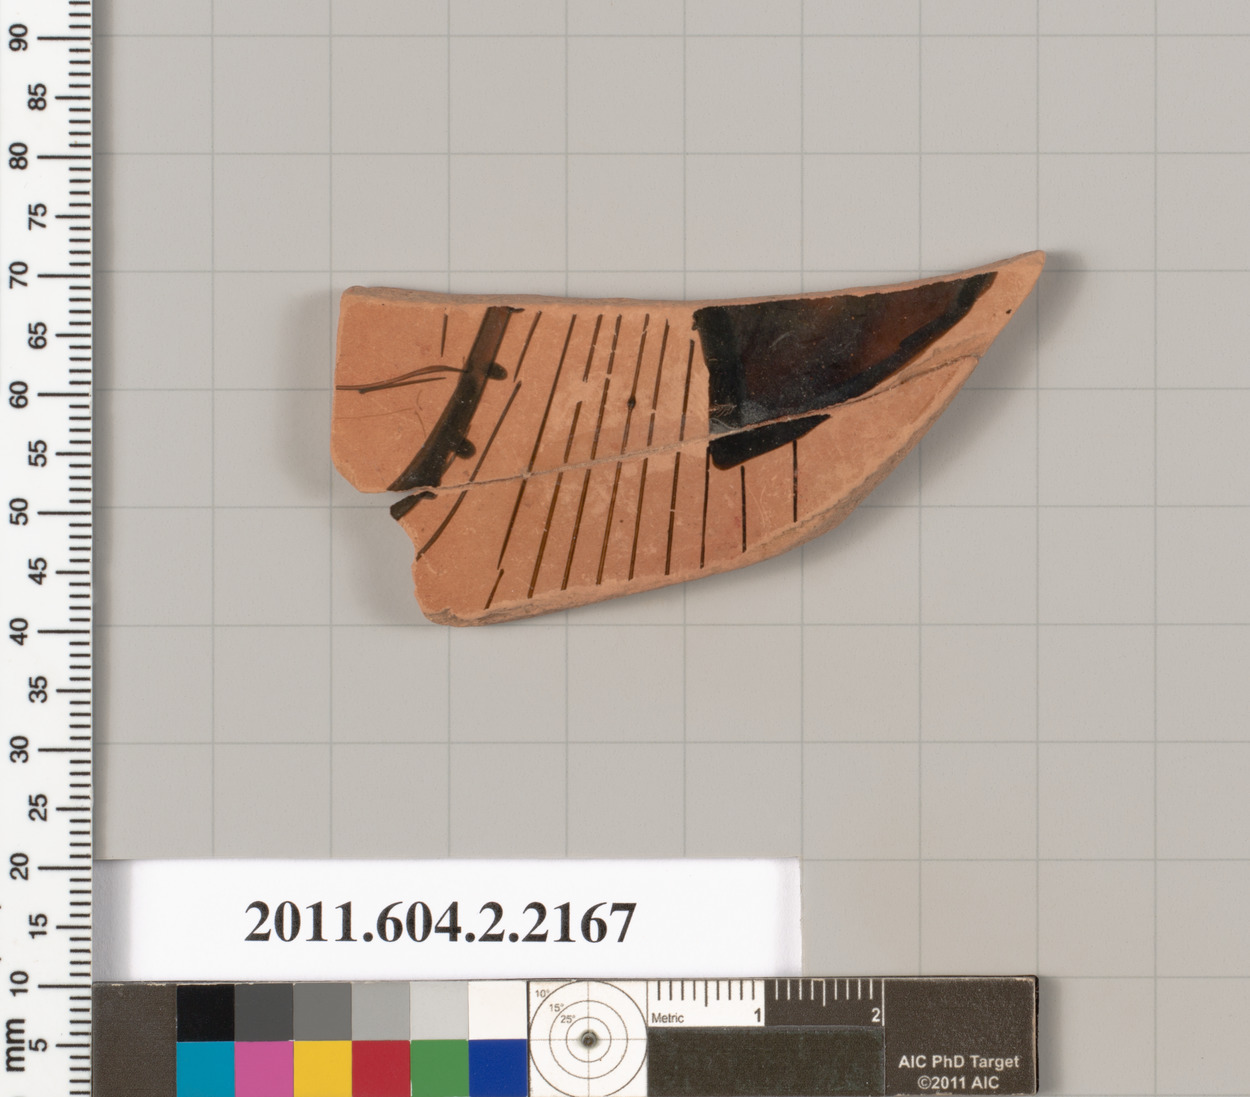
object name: pot fragment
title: Terracotta fragment of a pot; unglazed on the inside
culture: greek, attic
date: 450-426 BCE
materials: terracotta